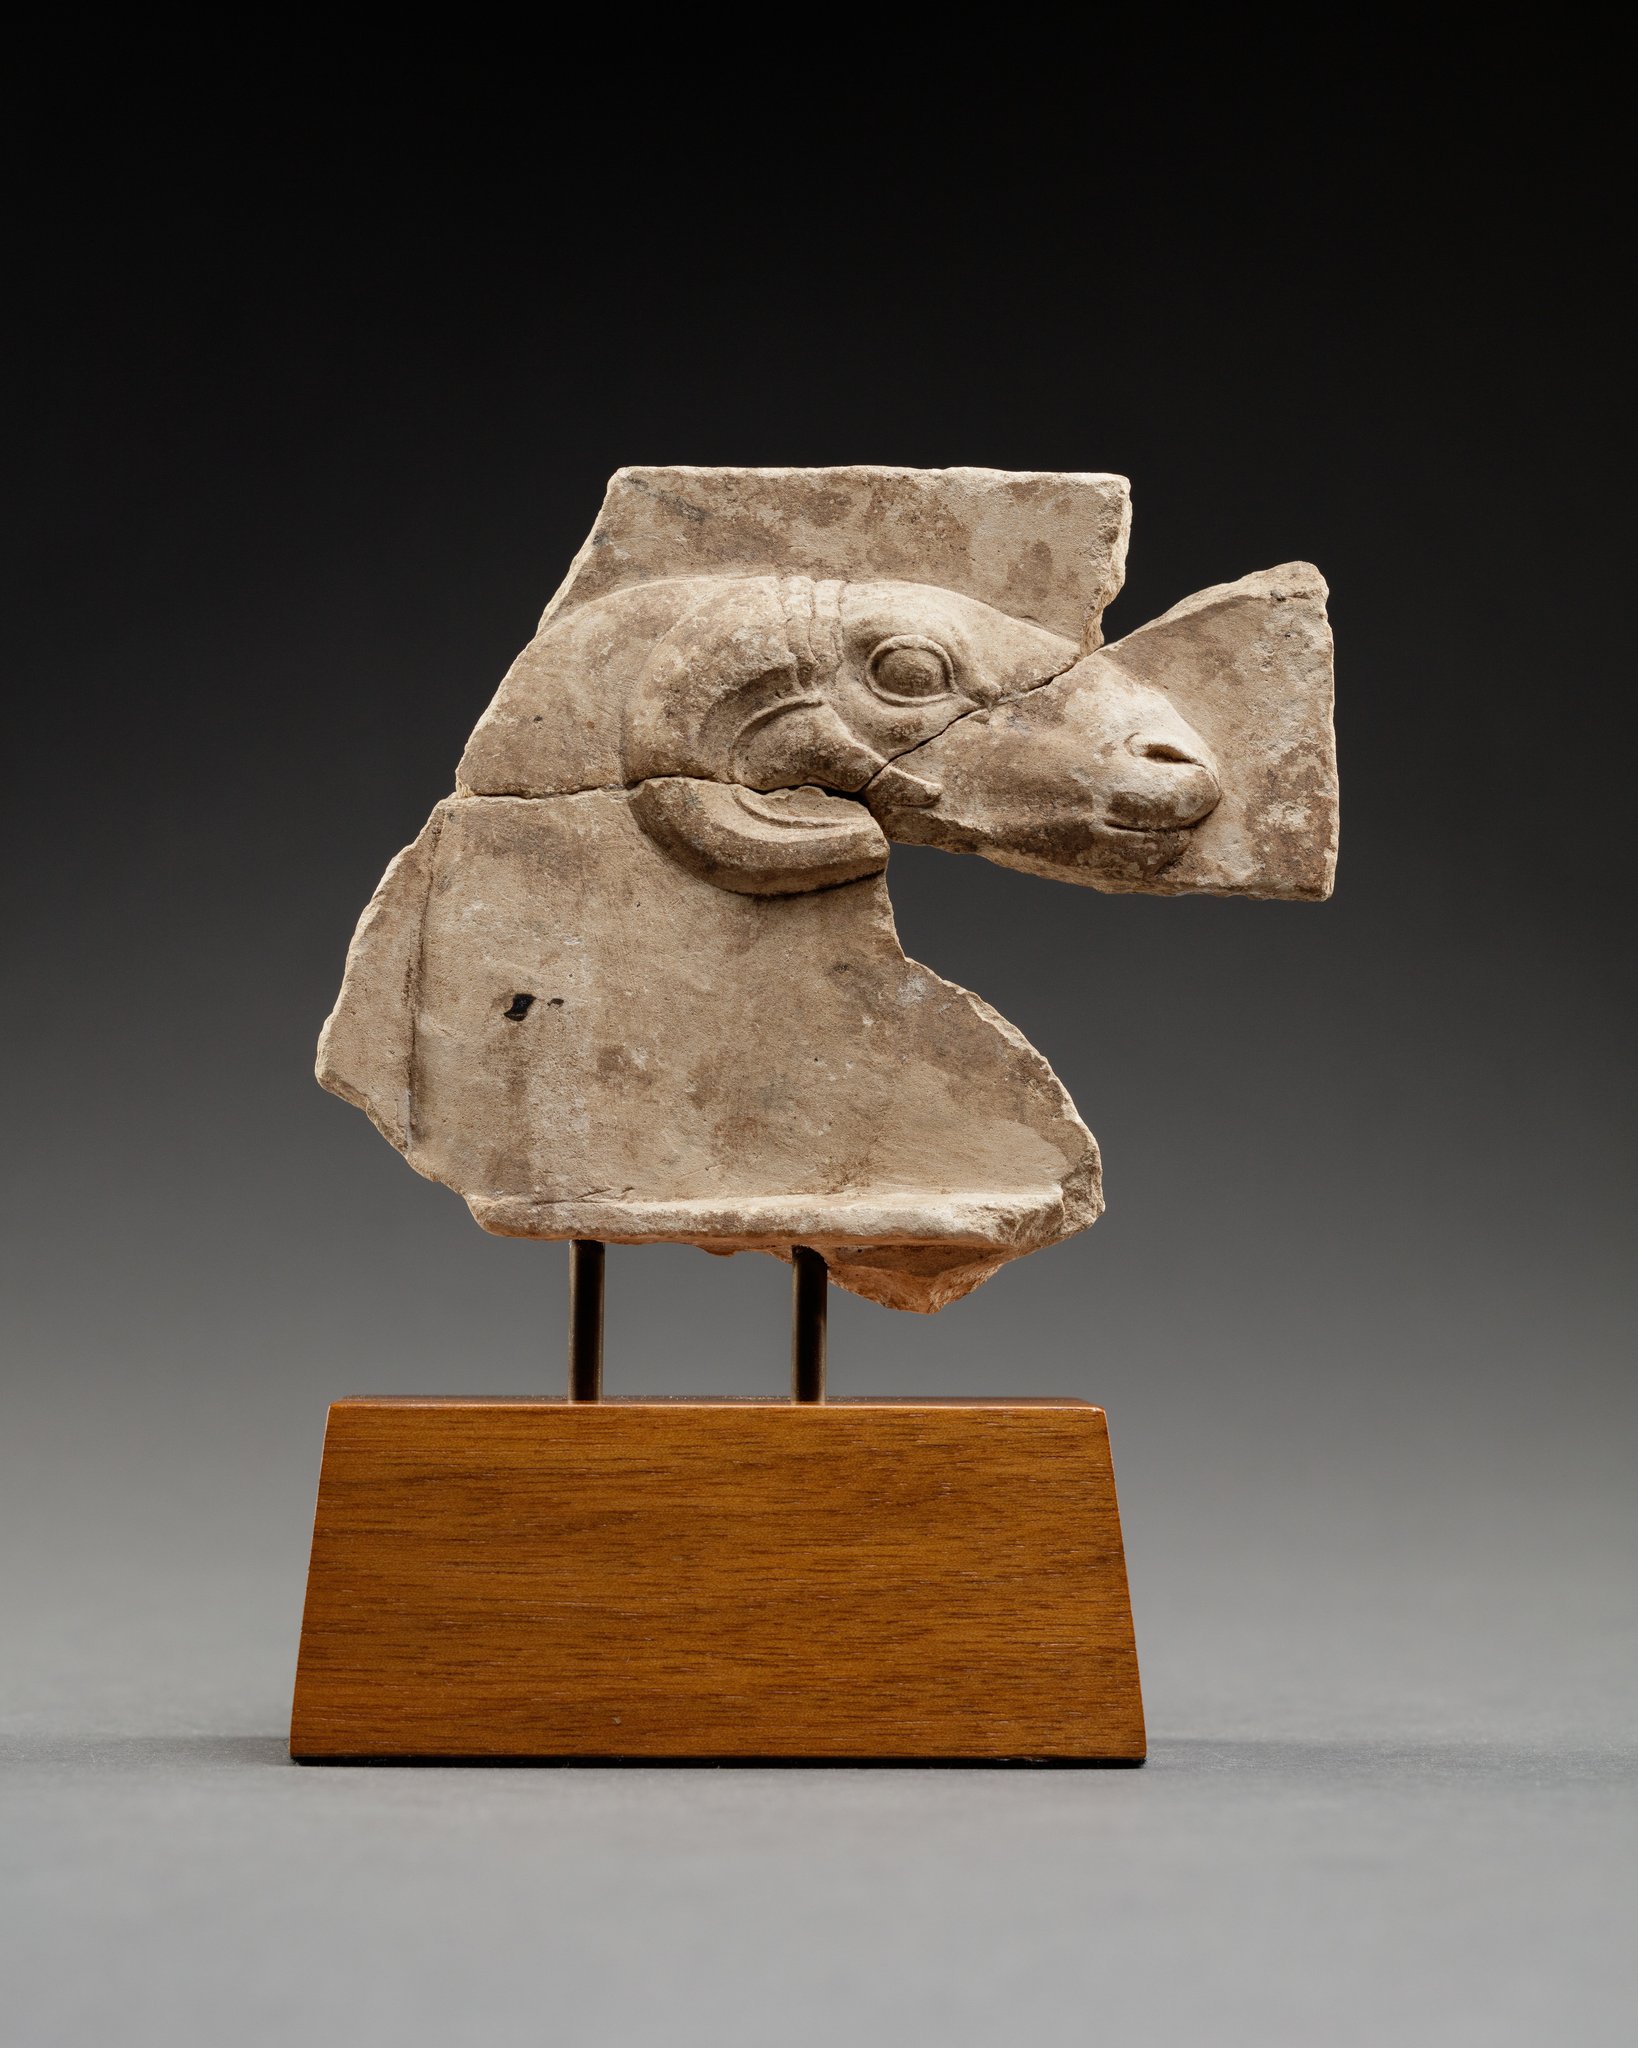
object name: relief, plaque, sculptor's model, donation, ram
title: Relief plaque with ram's head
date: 400-30 BCE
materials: limestone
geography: egypt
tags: rams